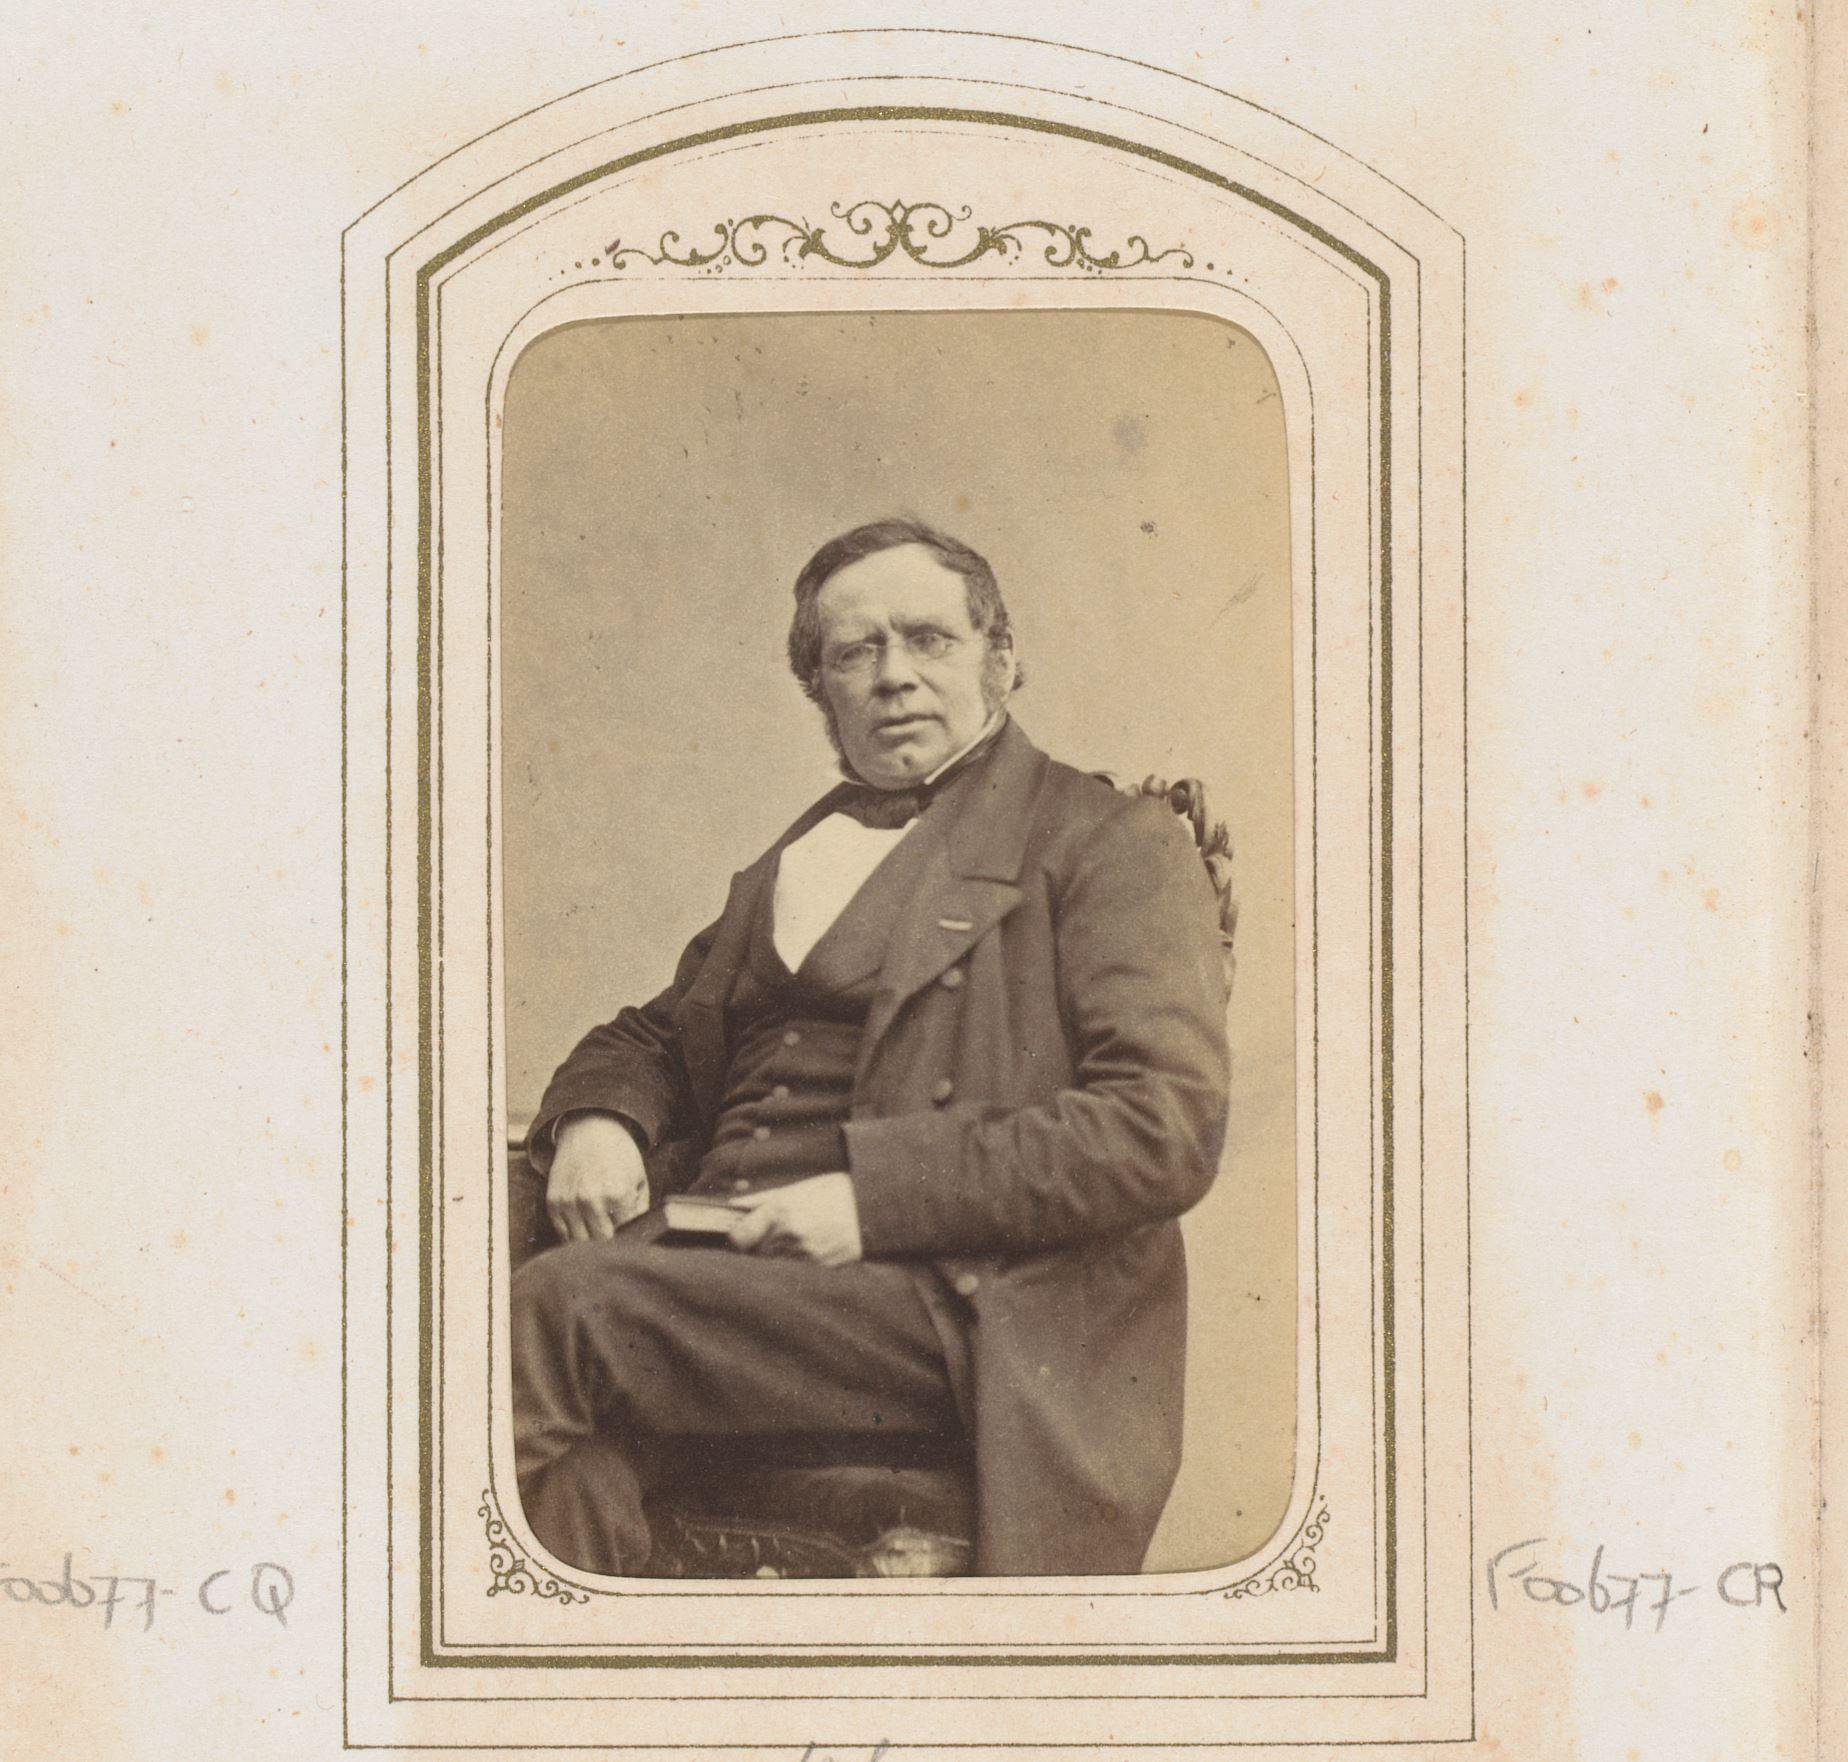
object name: album leaf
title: Portret van Ottho Gerhard Heldring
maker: maurits verveer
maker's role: painter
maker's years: 1817-1903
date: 1855-1876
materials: cardboard, photographic support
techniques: albumen print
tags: theologian, historical persons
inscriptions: name: ‘Heldrin[g]’, annotation: ‘Heldring’, inscription: ‘M. VERVEER/ PHOTOGRAPHE/ DE S.M. LE ROI DES PAIJS BAS/ 46, ZEESTRAAT, 46/ VIS A VIS DU WILLEMSPARK/ LA HAYE.’